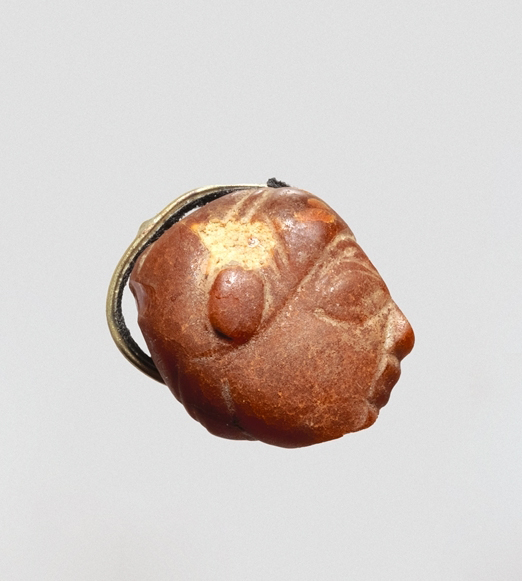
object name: head, winged female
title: Pendant: winged female head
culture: italic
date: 500-301 BCE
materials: amber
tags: heads,women